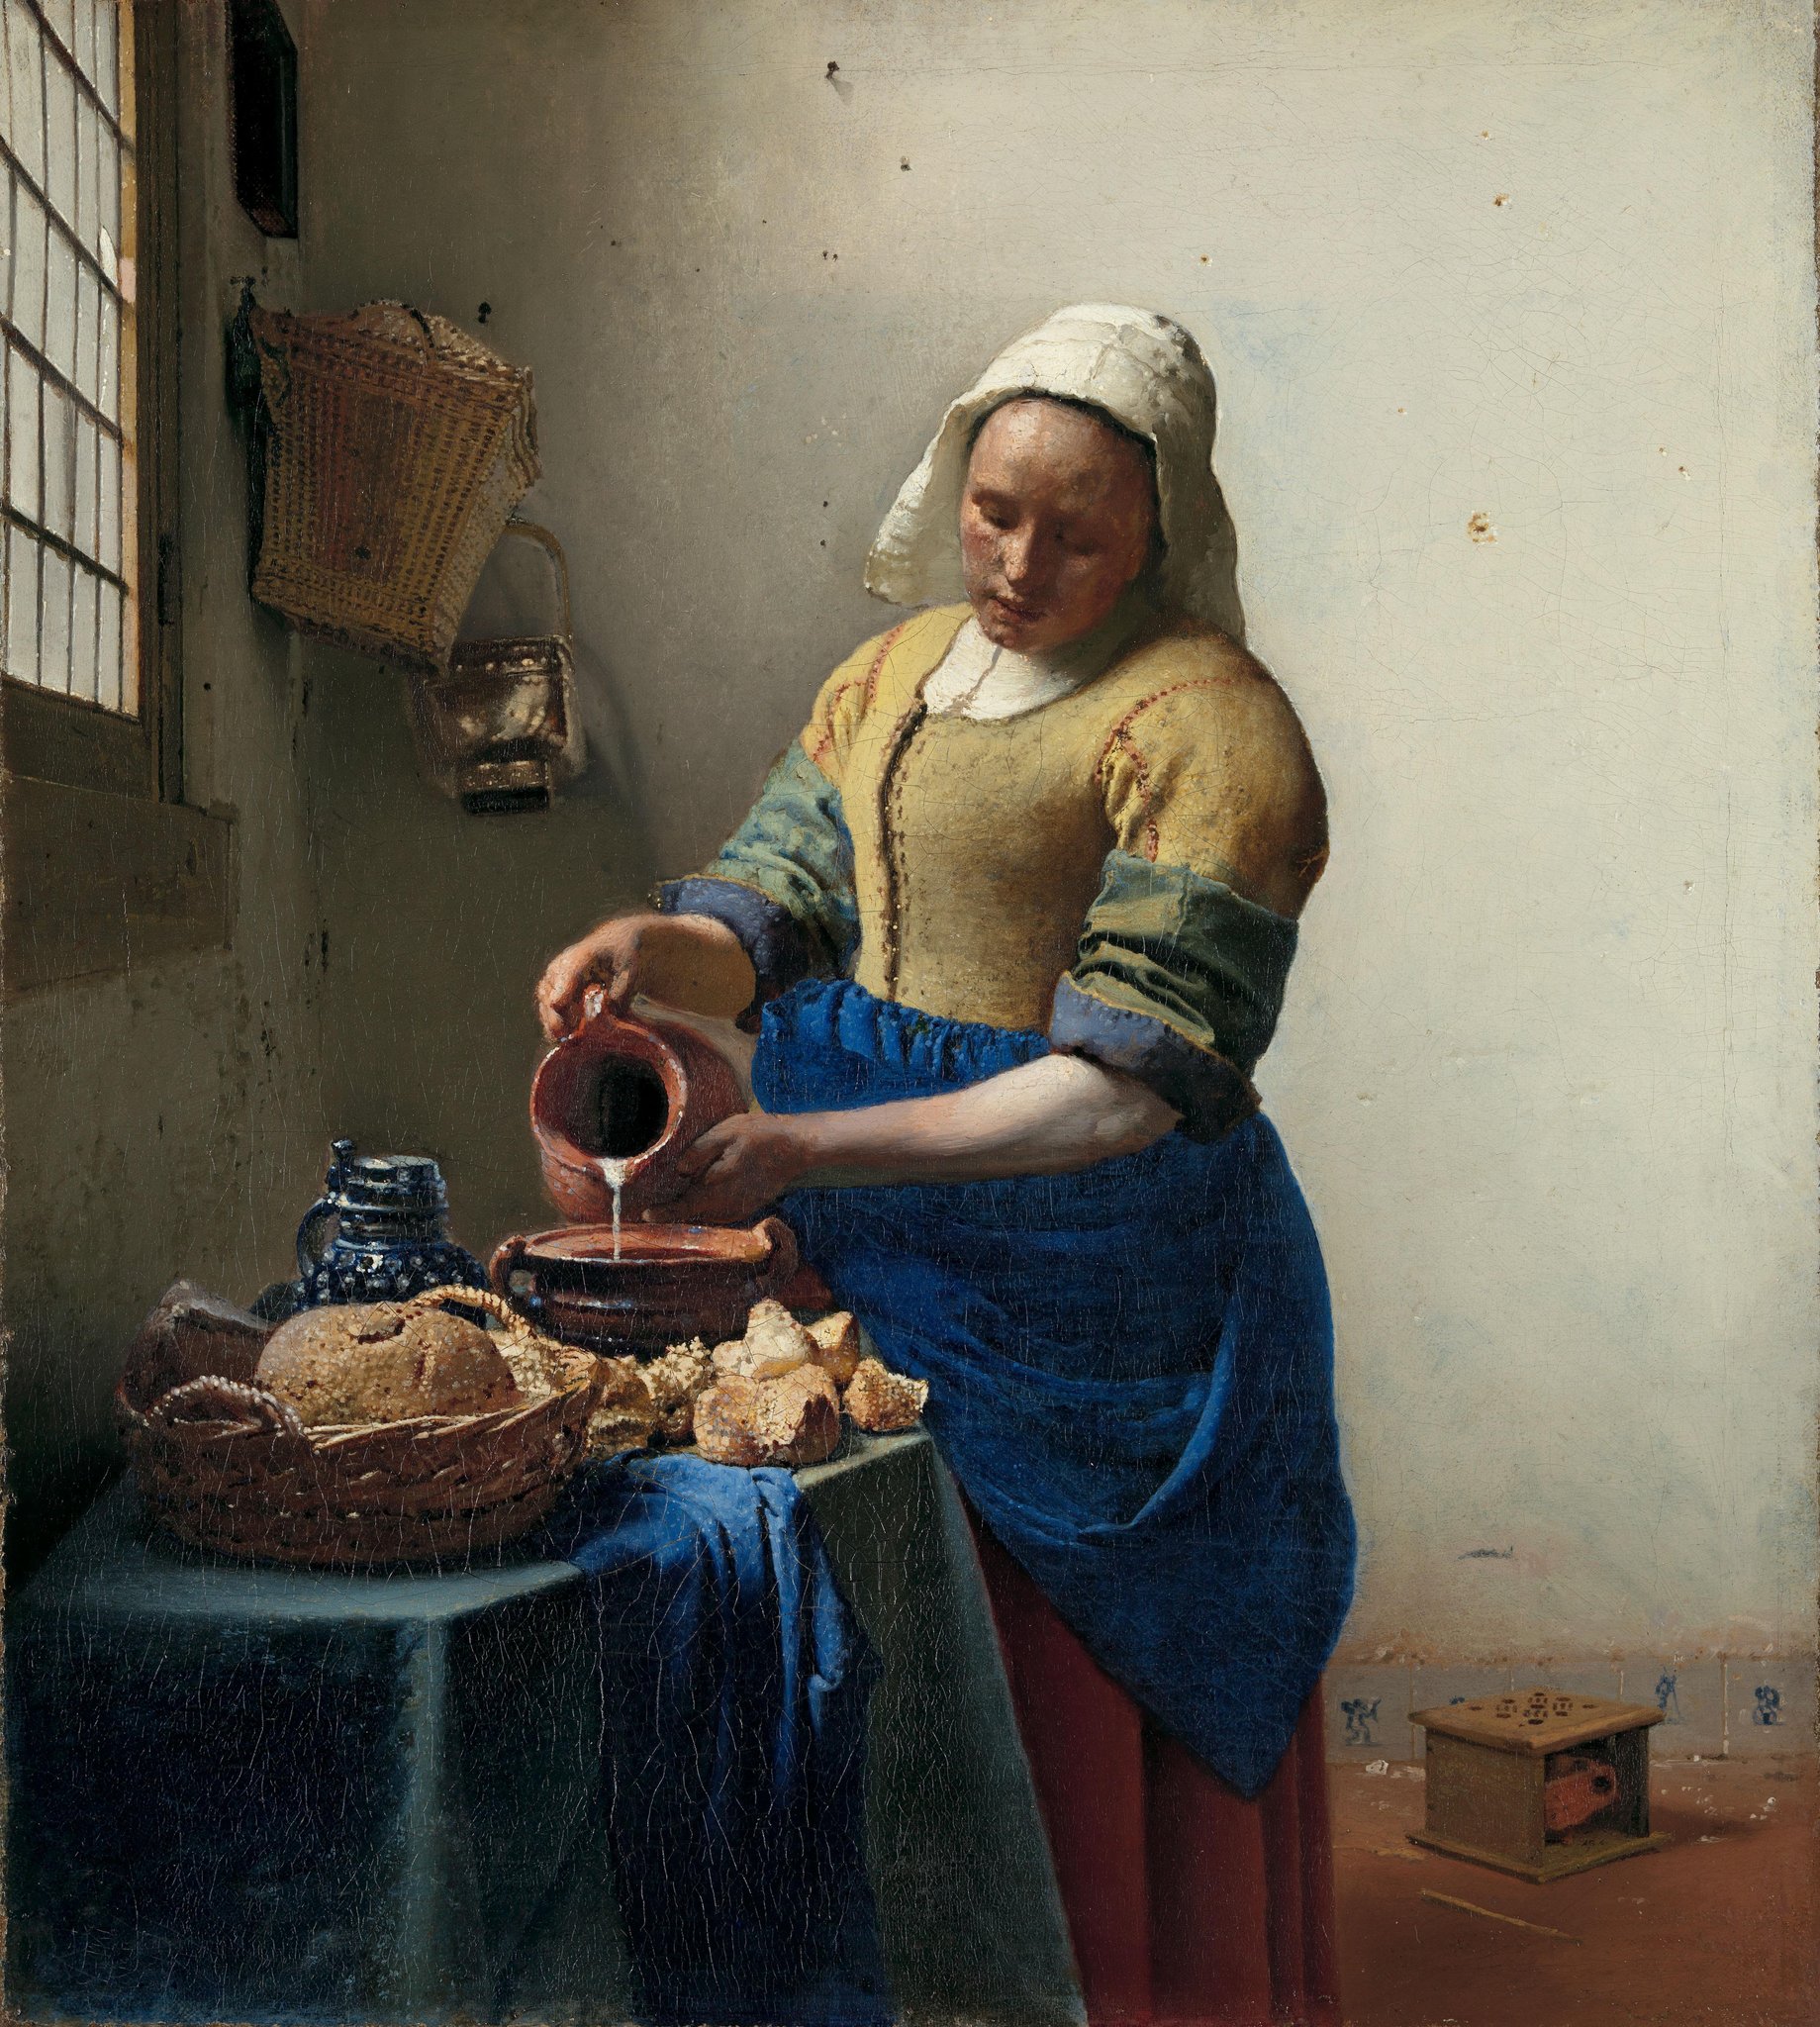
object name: painting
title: The Milkmaid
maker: johannes vermeer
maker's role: draughtsman, painter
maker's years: 1632-1675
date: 1660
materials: canvas, oil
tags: foot-stove, bread, loaf, container of ceramics: jar, jug, pot, vase, milk, milkmaid, kitchen-maid, kitchen servant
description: A maidservant pours milk, entirely absorbed in her work. Except for the stream of milk, everything else is still. Vermeer took this simple everyday activity and made it the subject of an impressive painting – the woman stands like a statue in the brightly lit room. Vermeer also had an eye for how light by means of hundreds of colourful dots plays over the surface of objects.